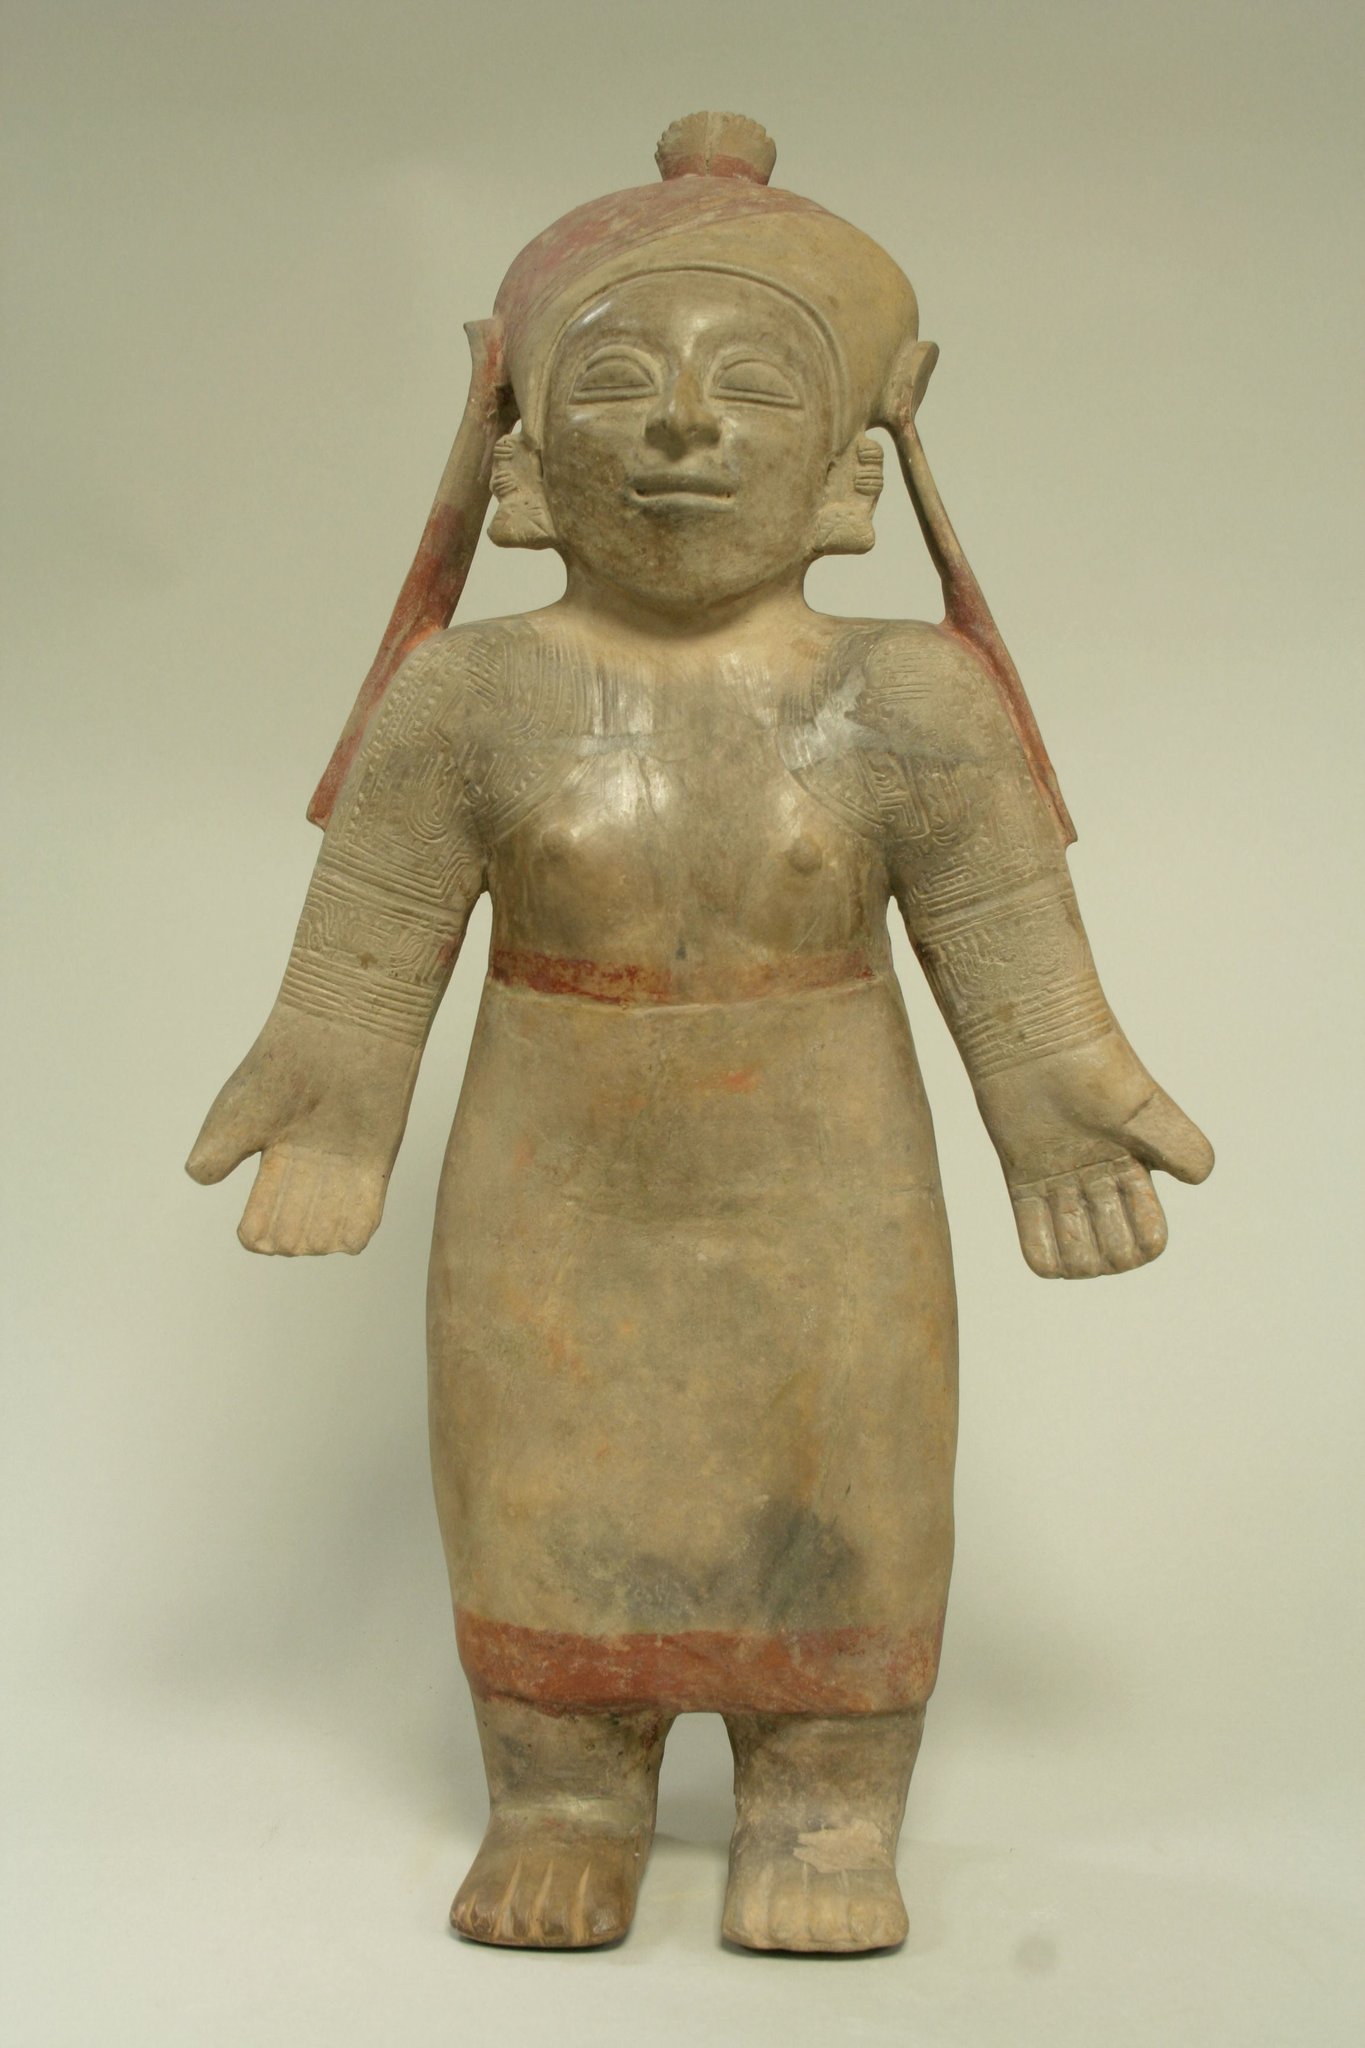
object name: female figure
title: Standing Ceramic Female Figure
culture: jama-coaque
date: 500 BCE-600 CE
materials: ceramic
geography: ecuador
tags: women